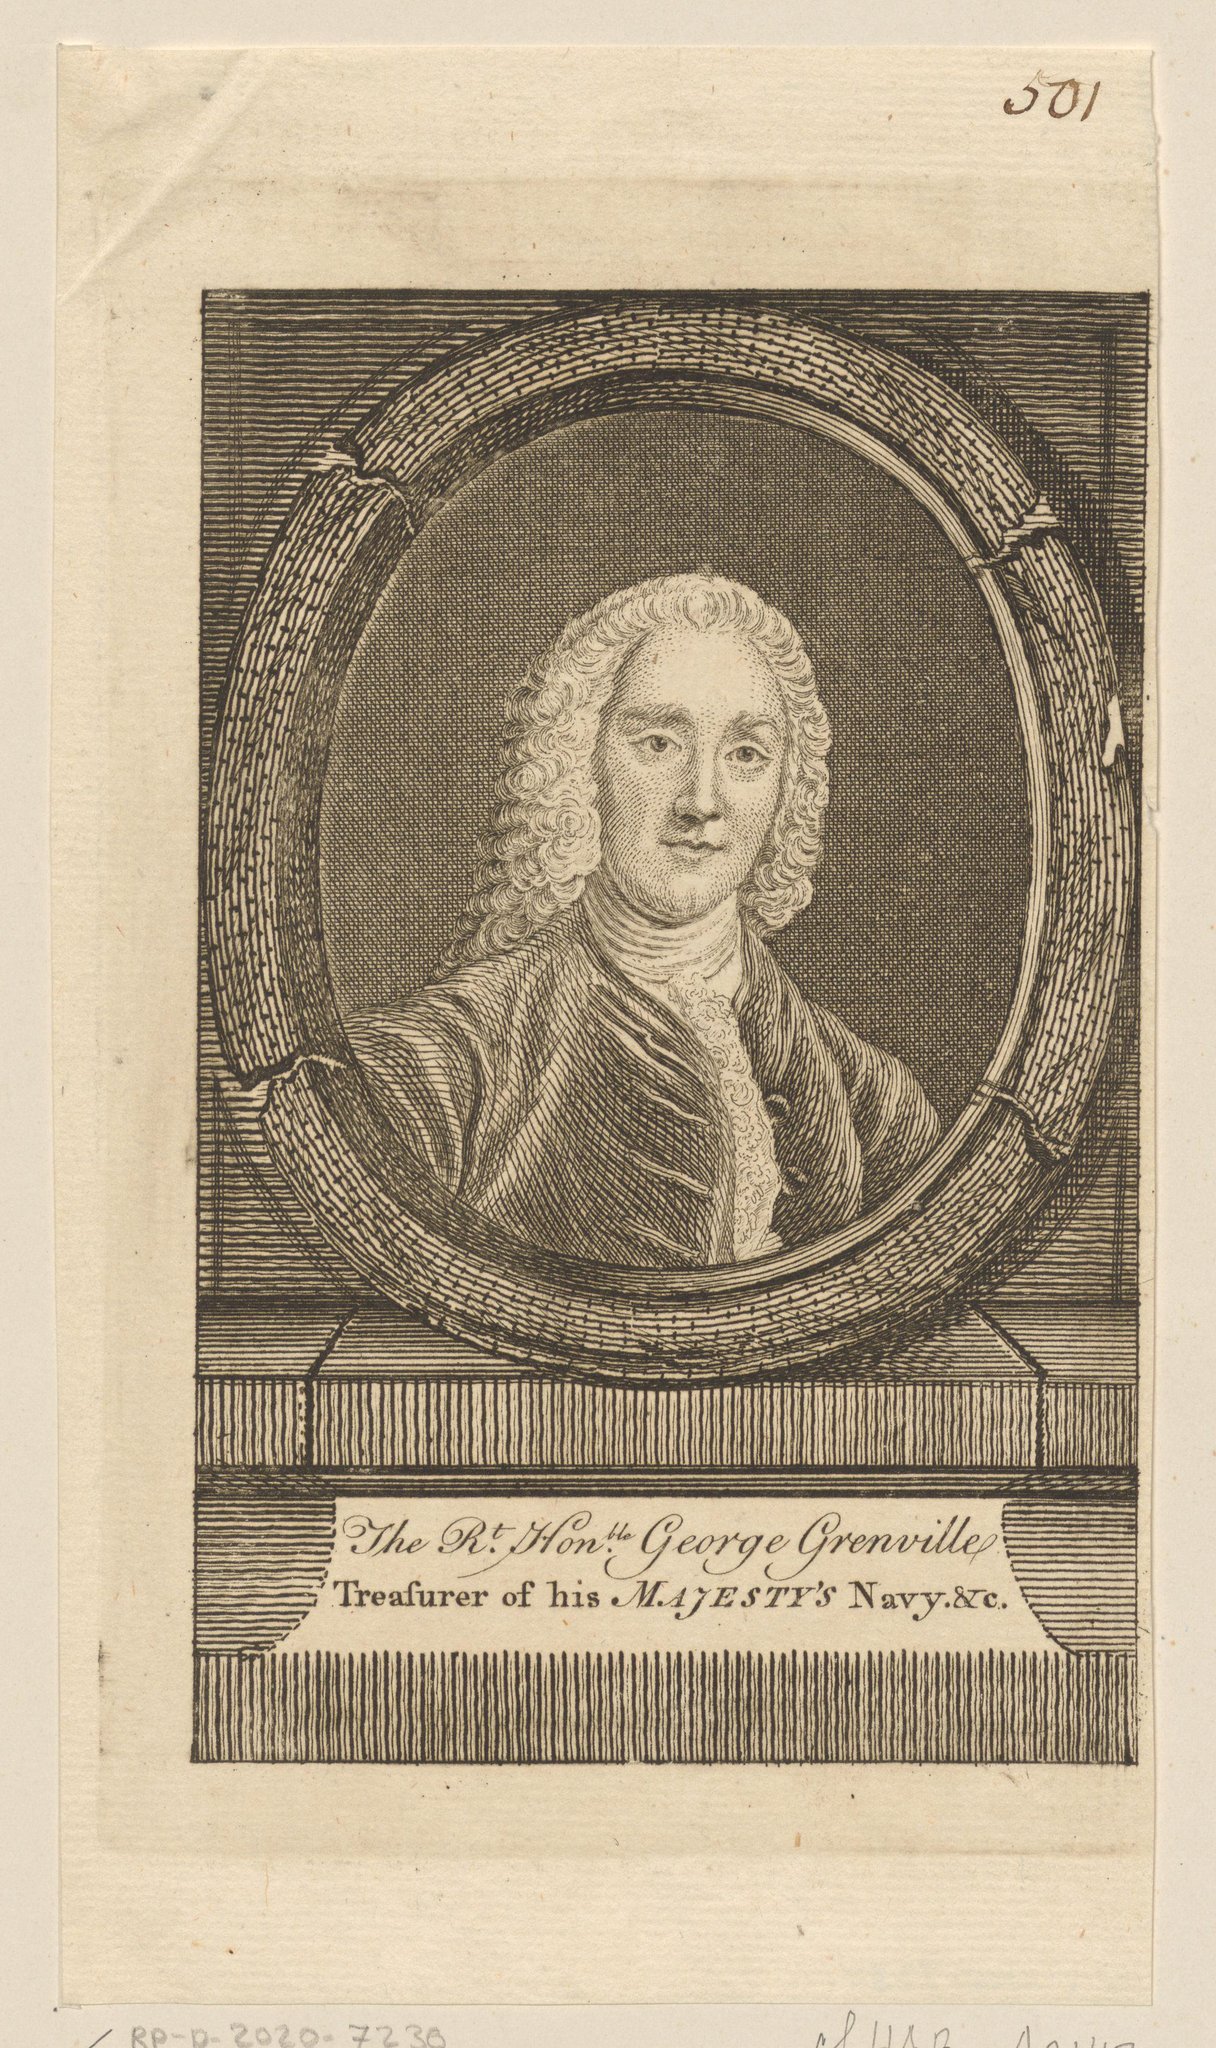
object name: print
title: Portret van George Grenville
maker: Anonymous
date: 1722-1770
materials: paper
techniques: engraving, etching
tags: london, politician, historical persons